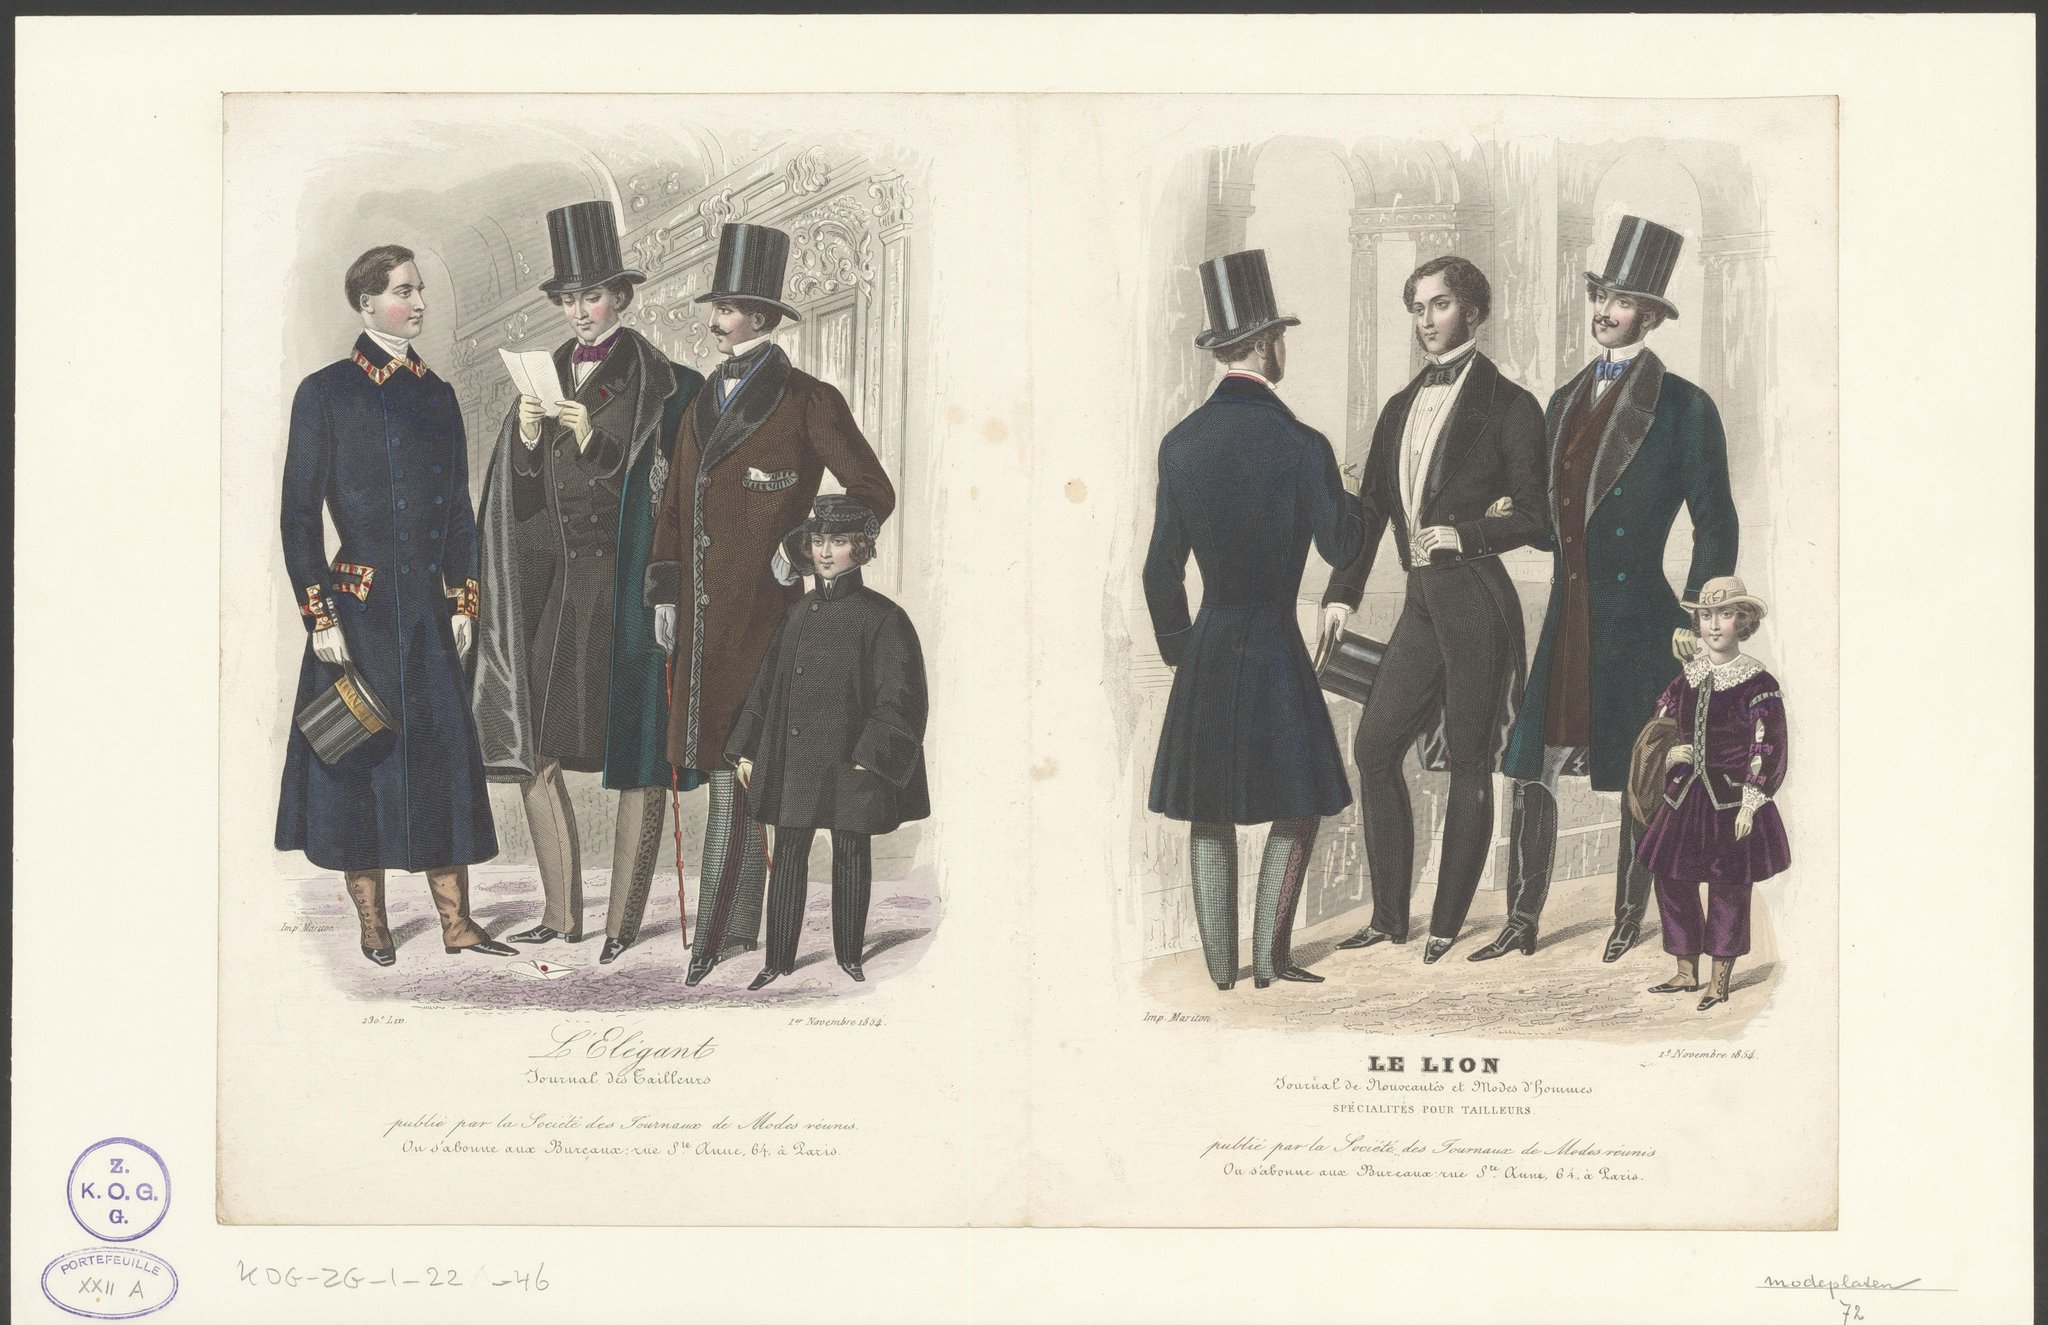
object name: print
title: Twee voorstellingen van herenmode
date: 1811-1854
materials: paper, watercolor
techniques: hand coloring, engraving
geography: paris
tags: fashion plates, clothes, costume (+ men's clothes)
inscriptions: collector's mark, collector's mark: Lugt 1641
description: Twee voorstellingen van herenmode, staande mannen en een jongen. Prent uit het modetijdschrift De Bazar, geïllustreerd Tijdschrift voor Modes en Handwerken (1857-1900). Onderwerpsrubrieken binnen de Atlas Zeden en Gewoonten: De Kleeding, Modeplaten.